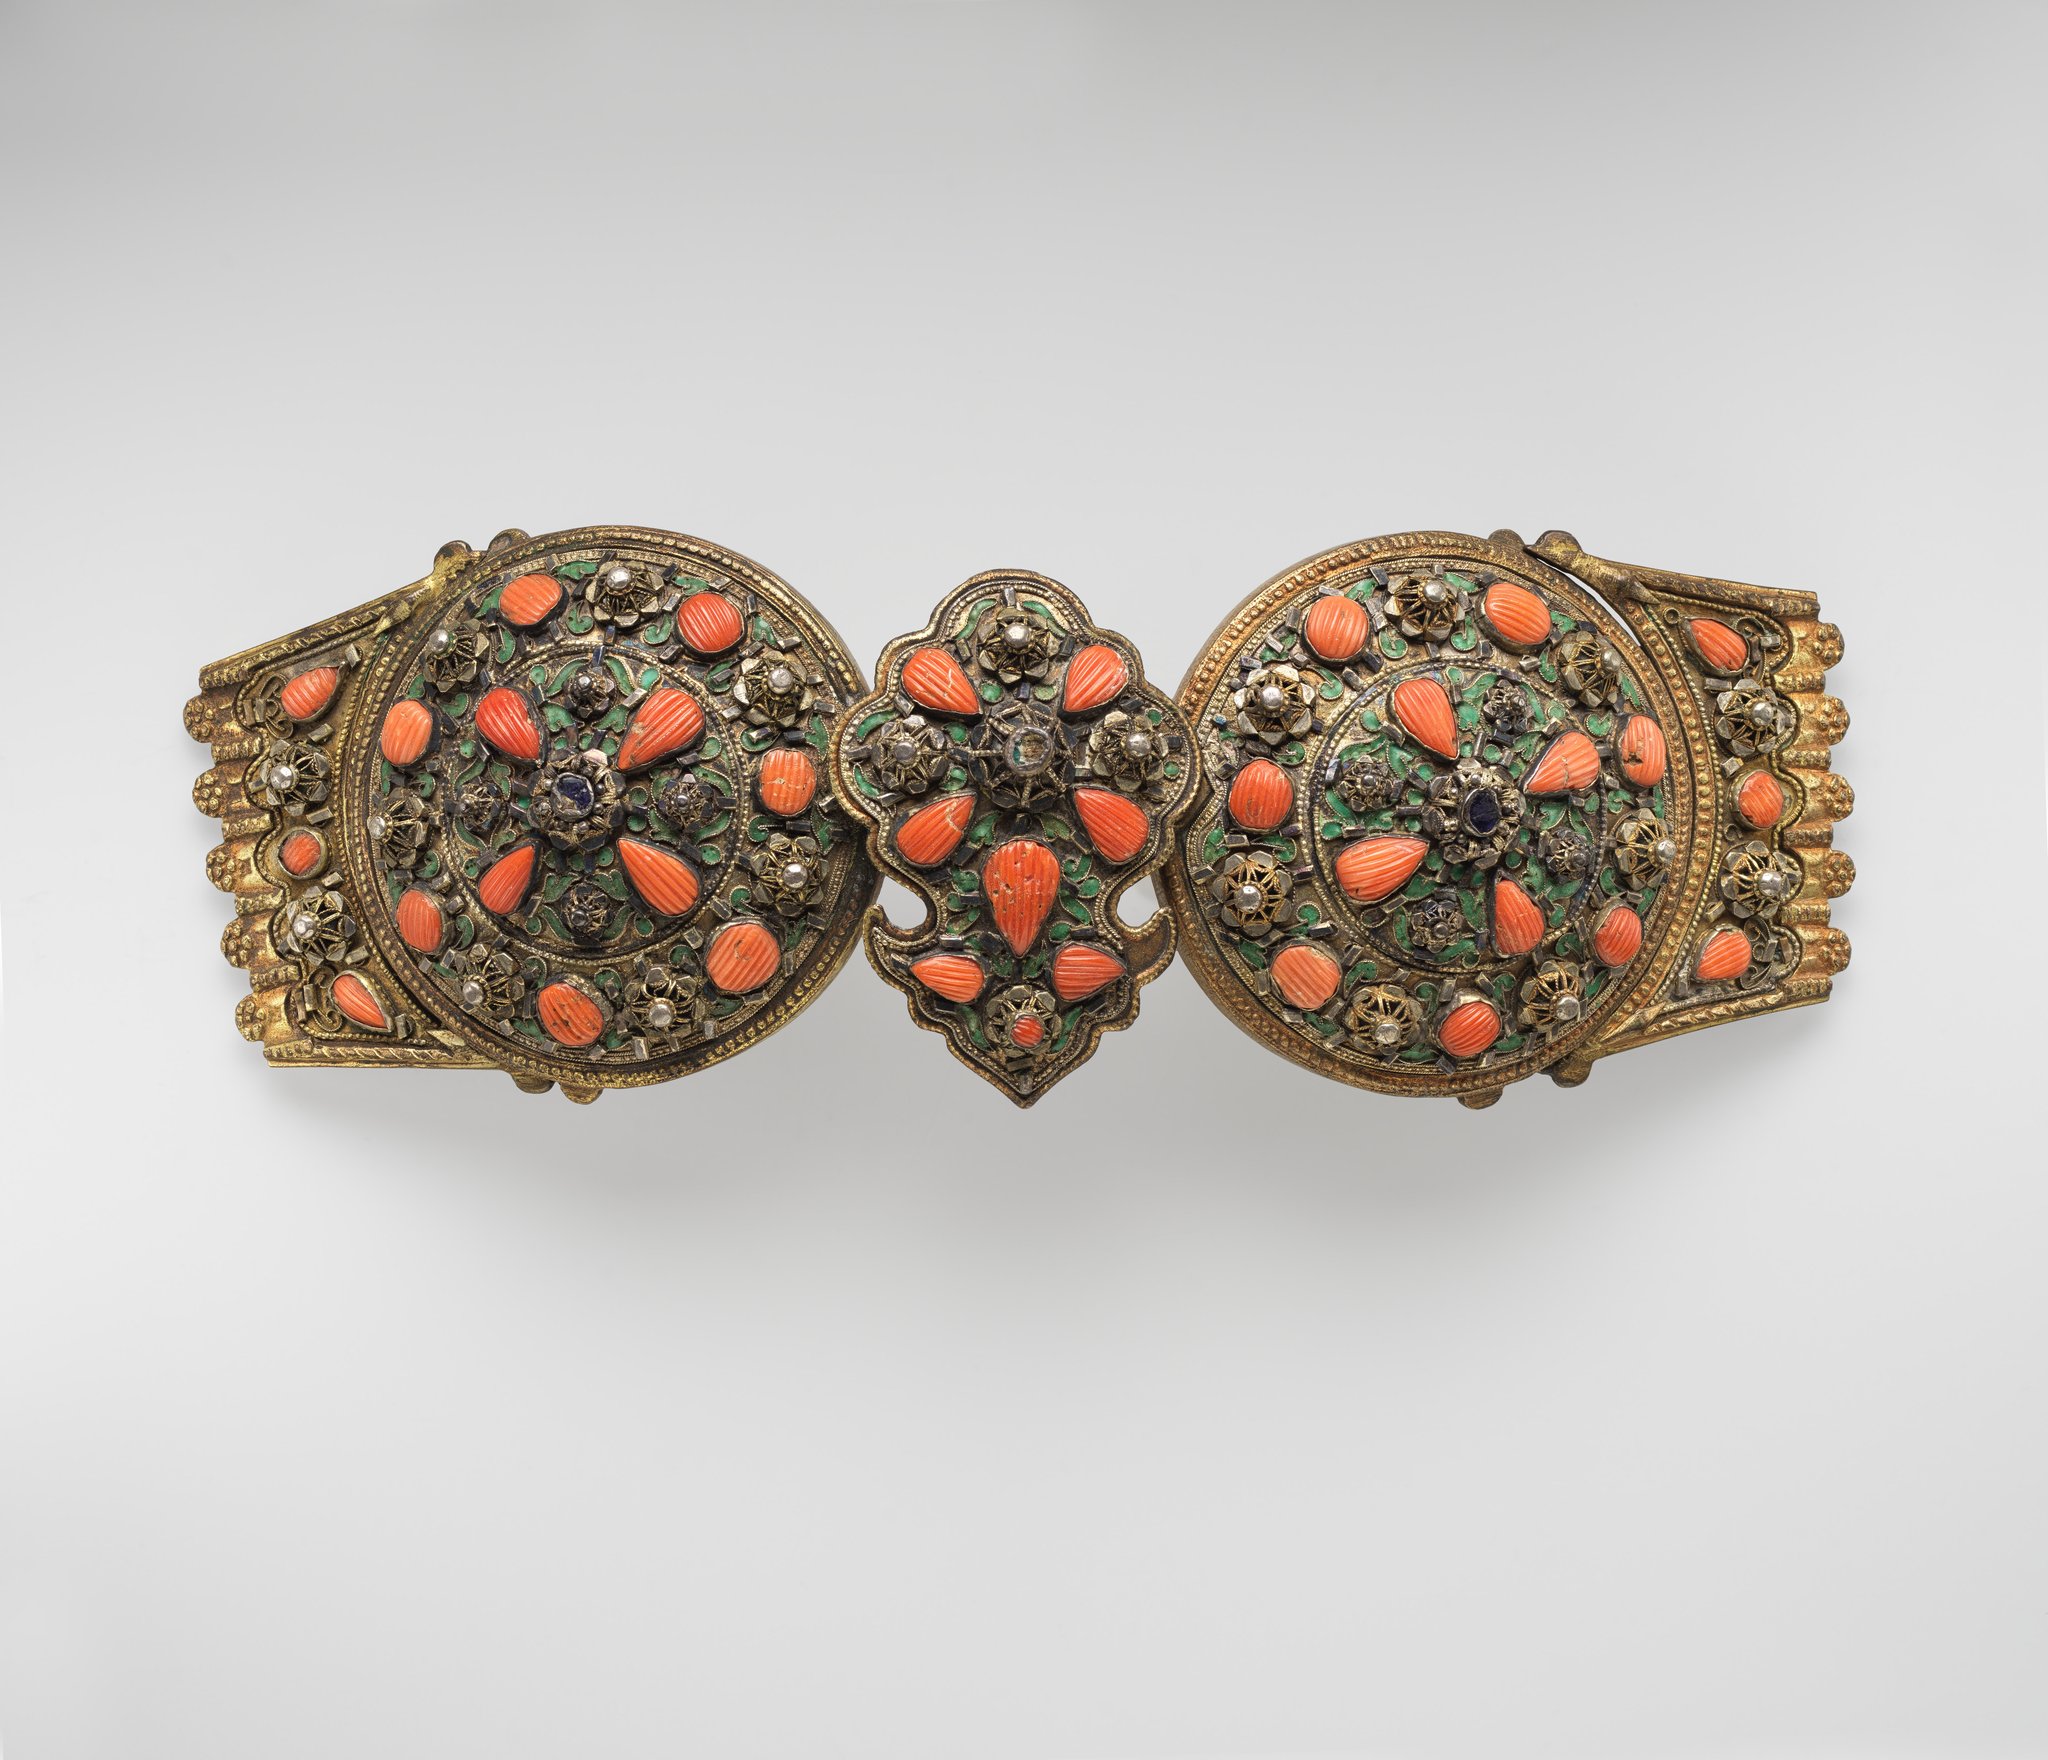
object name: girdle clasp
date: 1299-1923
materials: coral, gold, pearl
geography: turkey